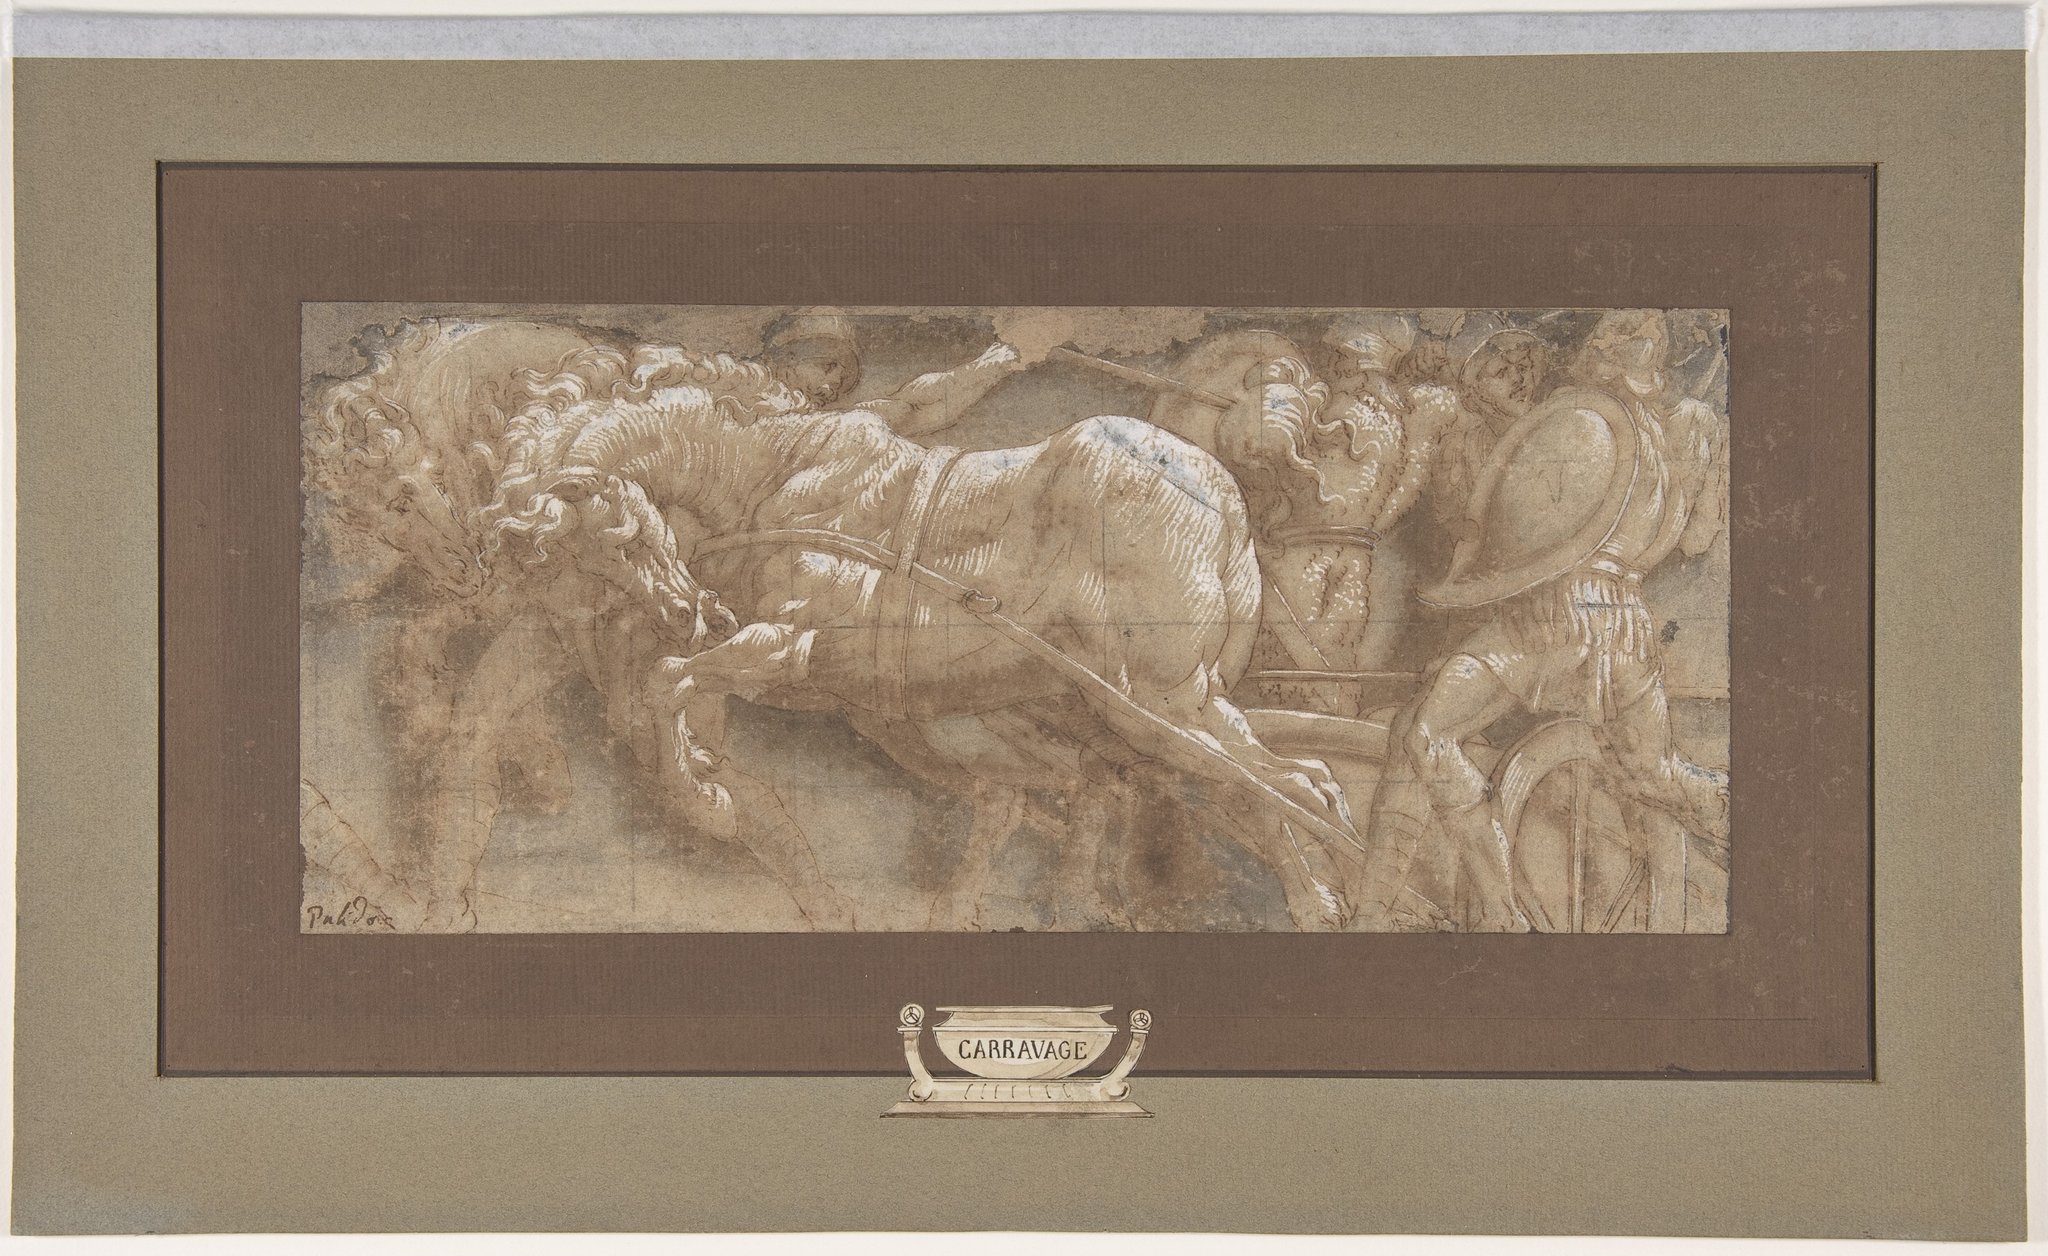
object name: drawing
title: Triumphal Scene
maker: lelio orsi (called lelio da novellara)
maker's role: artist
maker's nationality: italian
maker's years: 1508-1587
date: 1511-1587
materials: chalk, gouache, ink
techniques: brush, heightening, pen, wash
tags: soldiers,horses,chariots